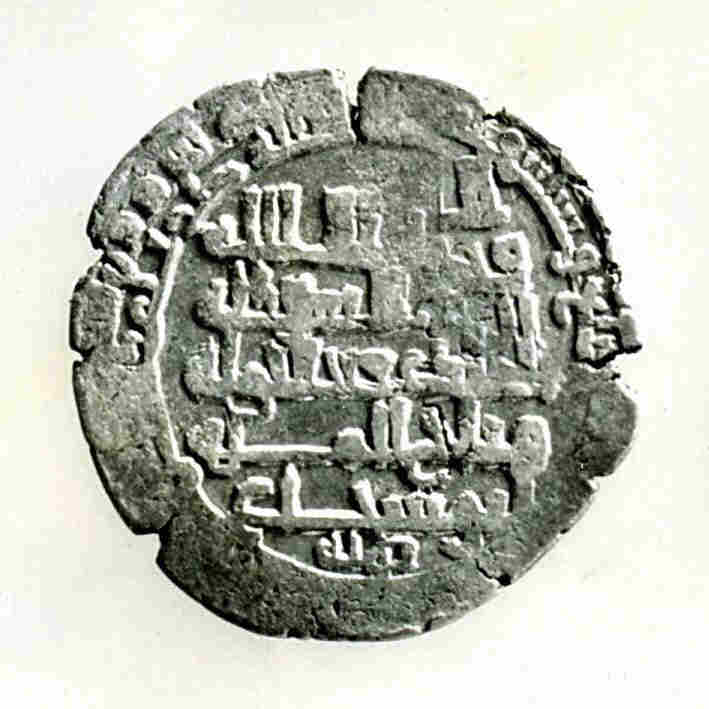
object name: coin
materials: silver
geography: iran